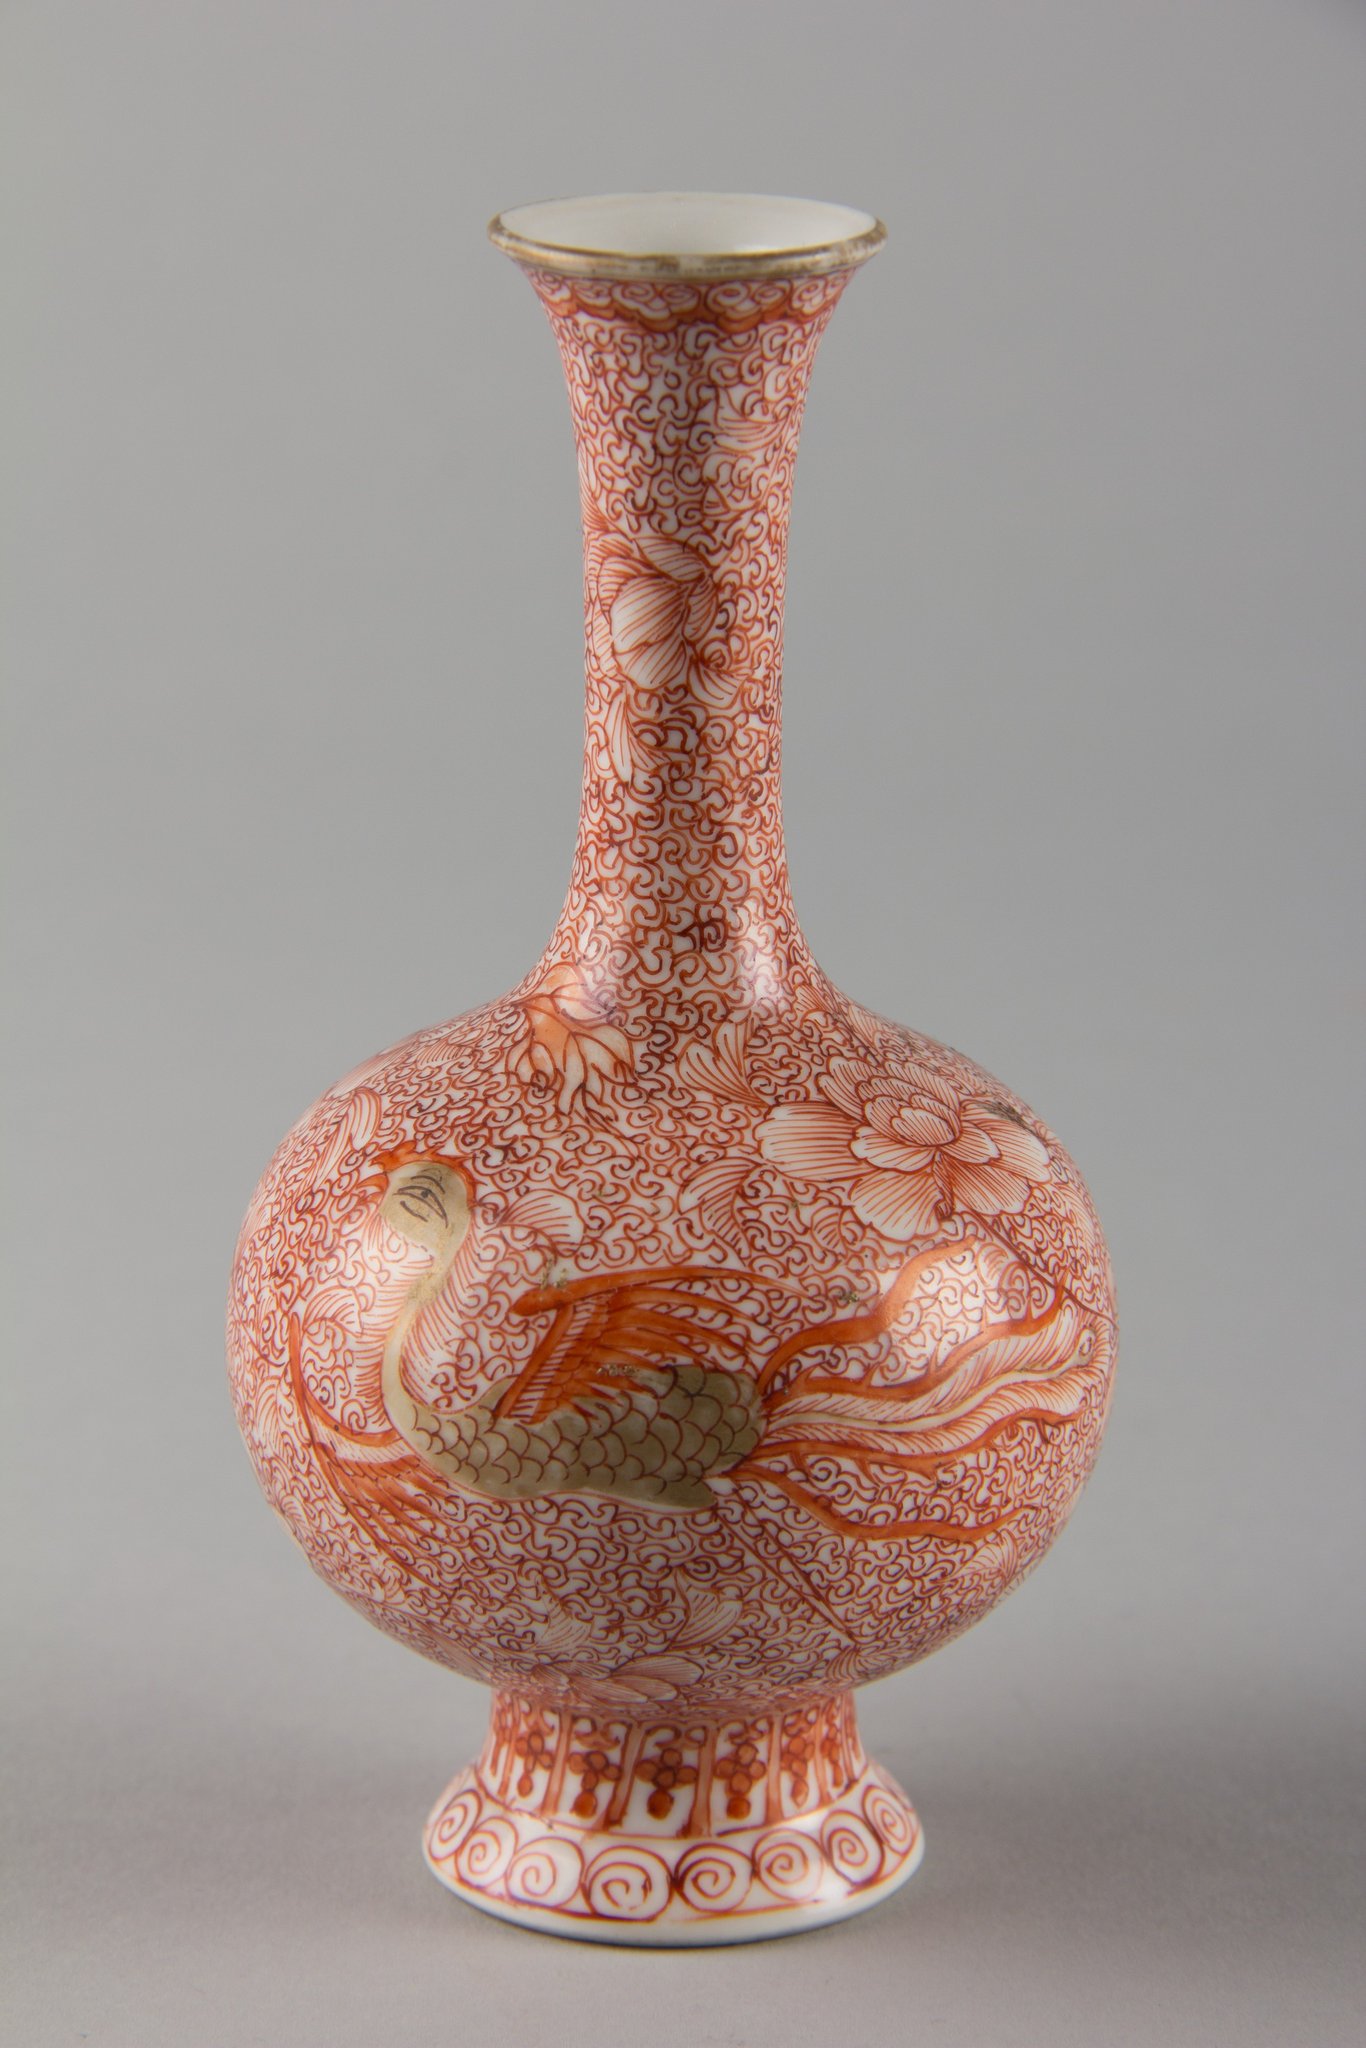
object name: vase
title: Vase with phoenix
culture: chinese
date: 1701-1800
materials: enamel, gold, pigment, porcelain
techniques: overglaze, painting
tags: phoenix